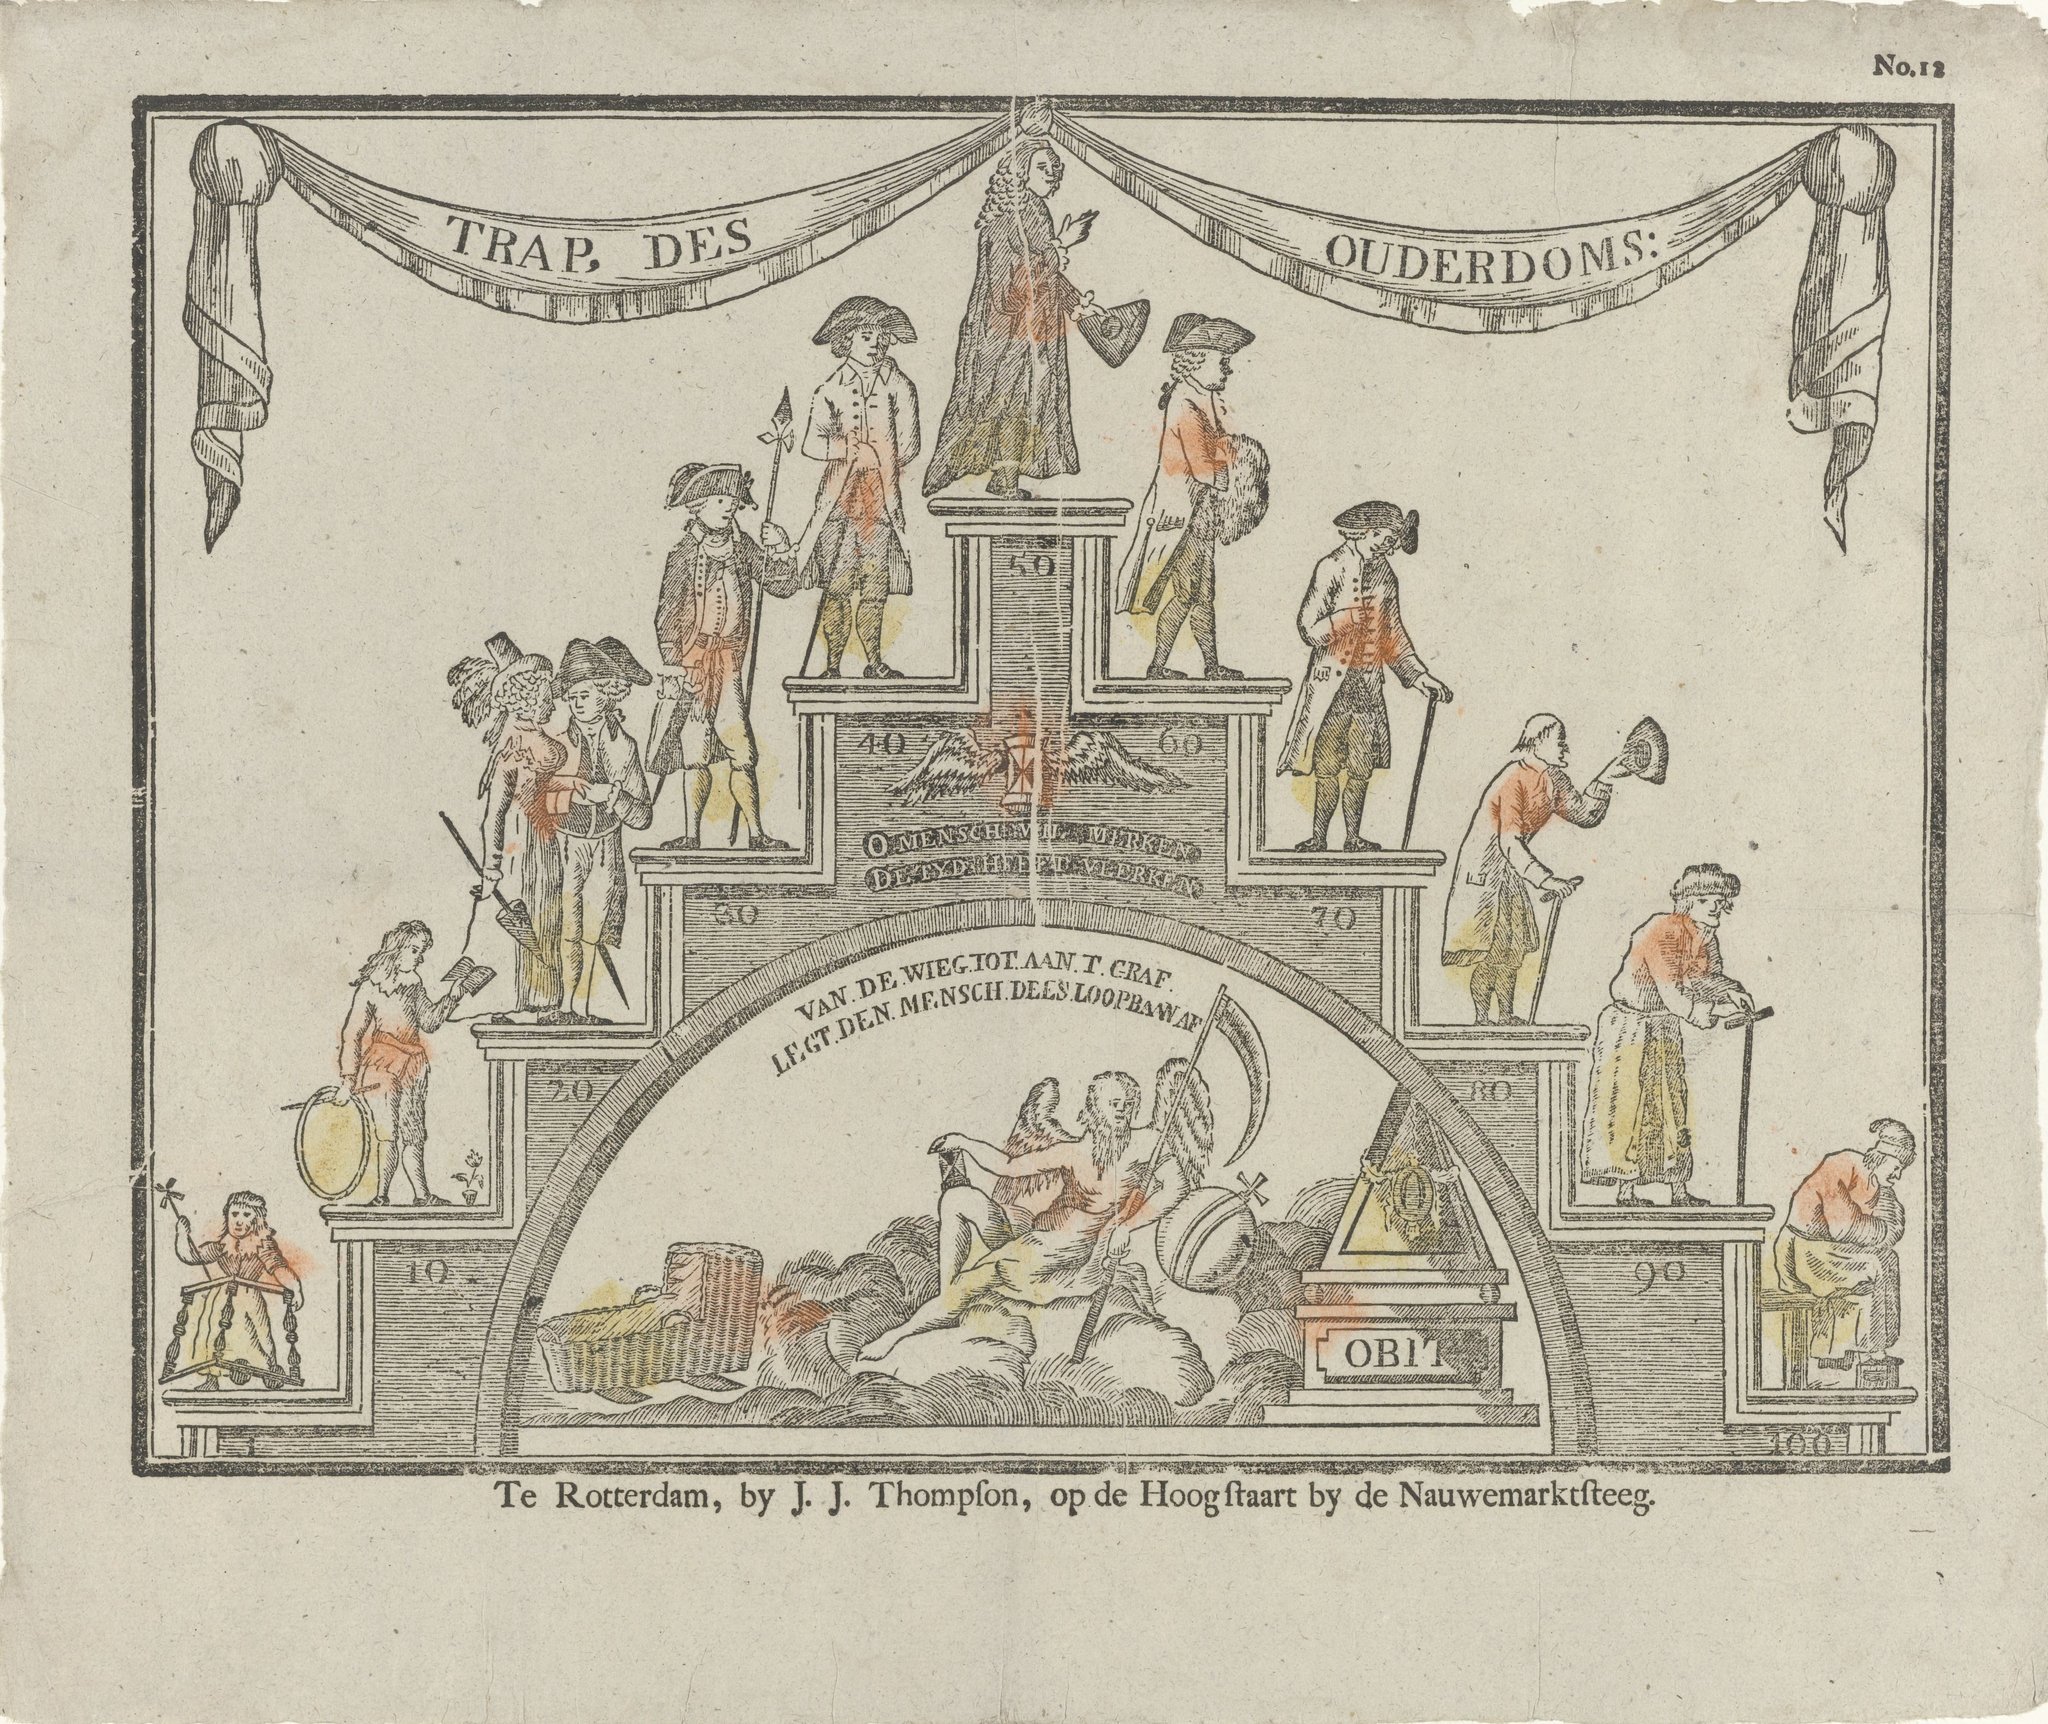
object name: print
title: Trap des ouderdoms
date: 1814-1825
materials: paper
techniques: colour, letterpress printing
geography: rotterdam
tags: the ages of man represented by a staircase, father time, man with wings and scythe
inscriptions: collector's mark: Lugt 2760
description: Een trap des ouderdoms: een mannentrap. Op de treden van de trap, in de vorm van een brug, staan mannen in de leeftijd van 0 tot 100 jaar. Onder de brug een personificatie van de tijd. Genummerd rechtsboven: No. 12.